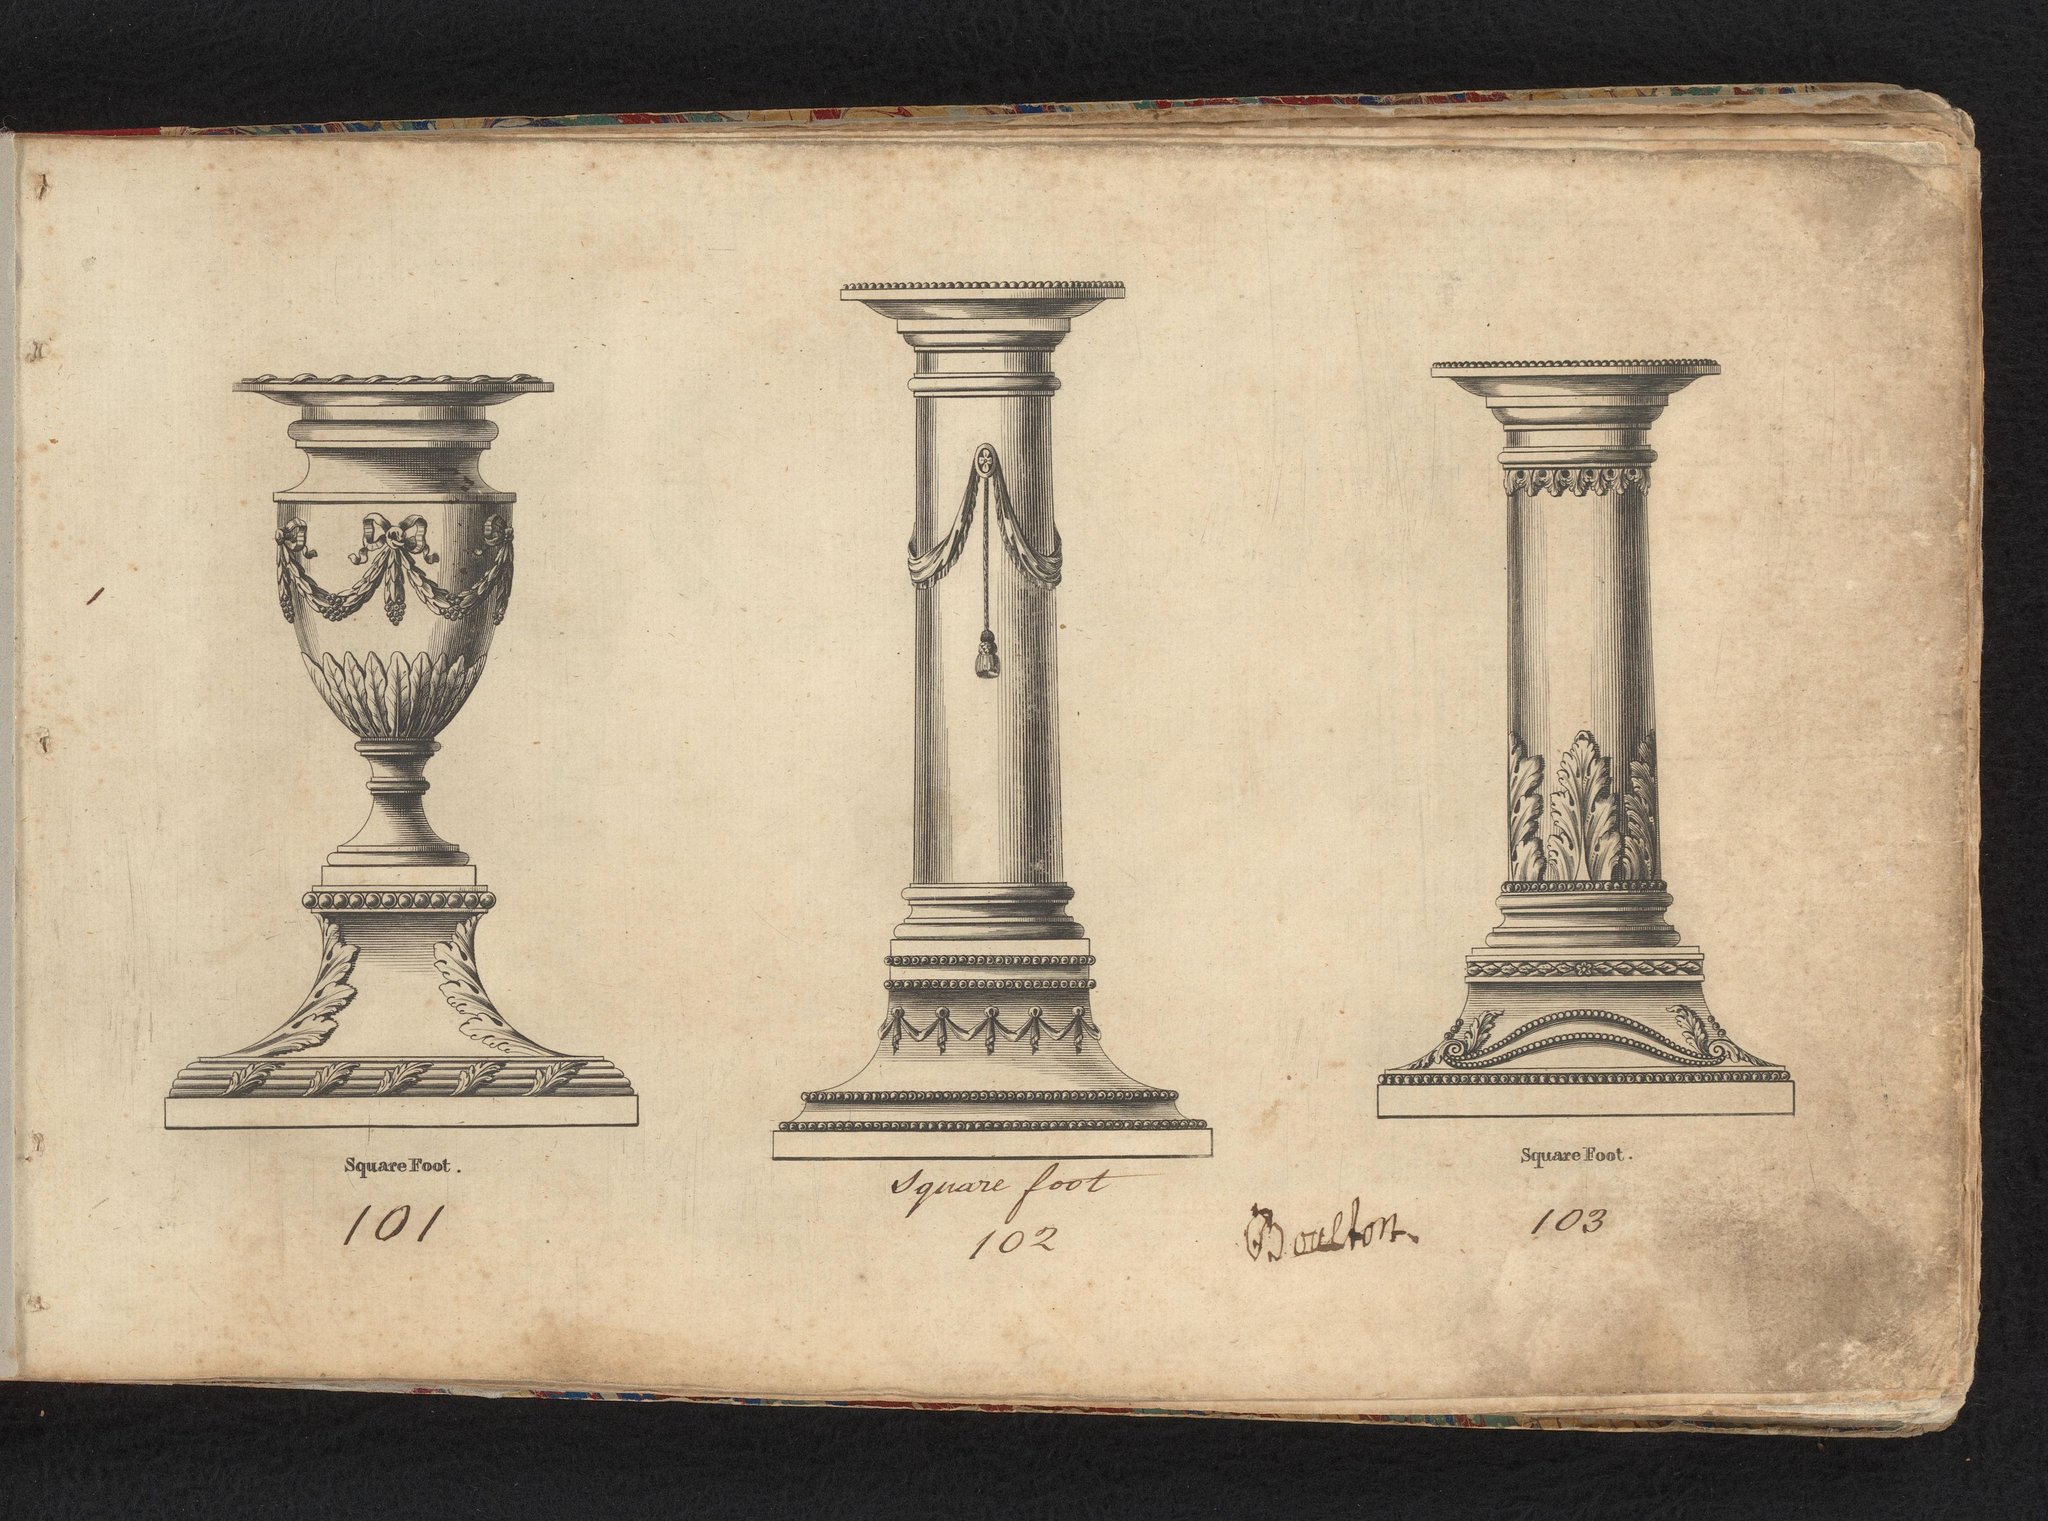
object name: print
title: Drie ontwerpen voor kandelaren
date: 1784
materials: paper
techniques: engraving, etching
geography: england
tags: candlestick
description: Drie ontwerpen voor kandelaren met vierkante voeten, op het volle blad. Met gedrukte onderschriften en handgeschreven nrs 101-103 en de naam 'Boulton'. Onderdeel van een catalogus met assortiment modellen van Sheffield verzilverd vaatwerk (pleet) door Matthew Boulton.